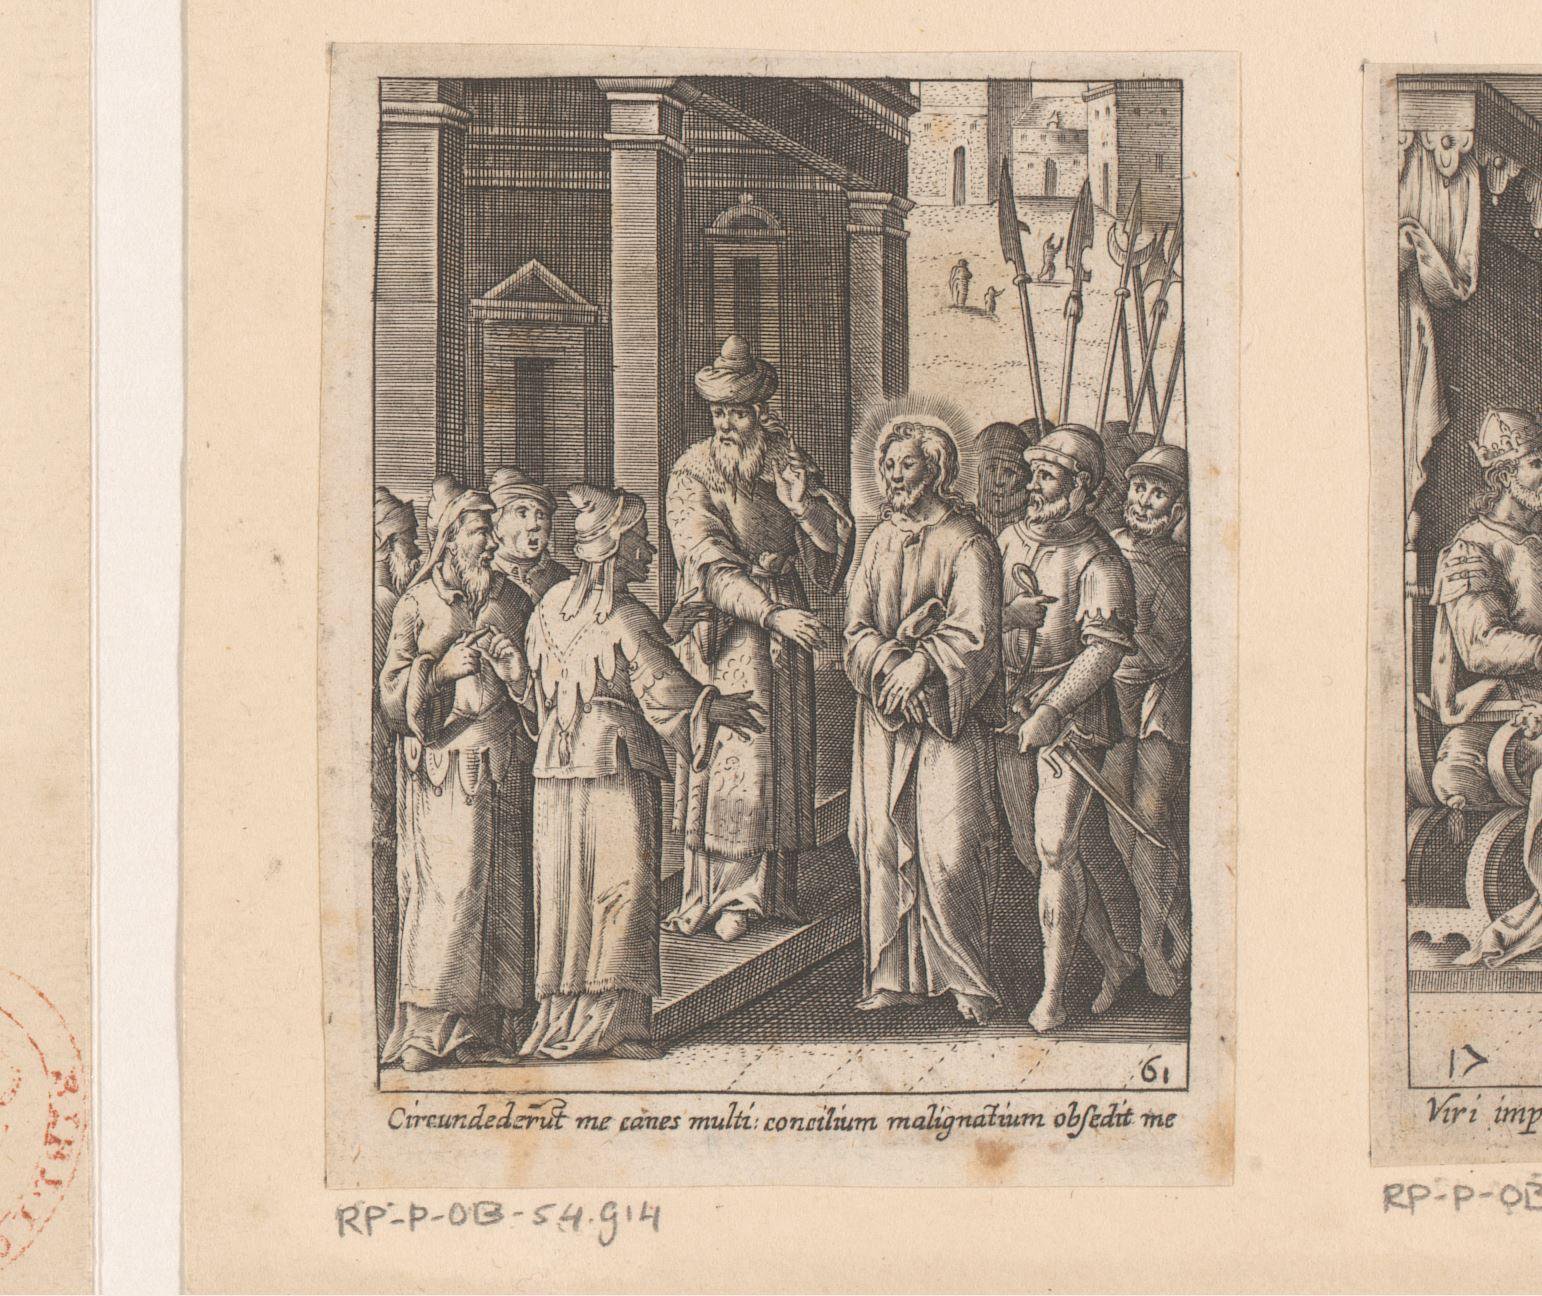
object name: print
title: Christus voor Kajafas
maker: heinrich ulrich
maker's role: draughtsman, painter, print maker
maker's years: 1572-1671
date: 1582-1671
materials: paper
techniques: engraving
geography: germany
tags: christ before the sanhedrin with caiaphas as high priest, and possibly annas; maybe a soldier about to strike christ because he keeps silent (matthew 26:57-66; mark 14:53-64; luke 22:54, 22:66-71)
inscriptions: number: ‘38. - 64.’, collector's mark: Lugt 240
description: Spiegelbeeldig genummerd rechtsonder: 16.